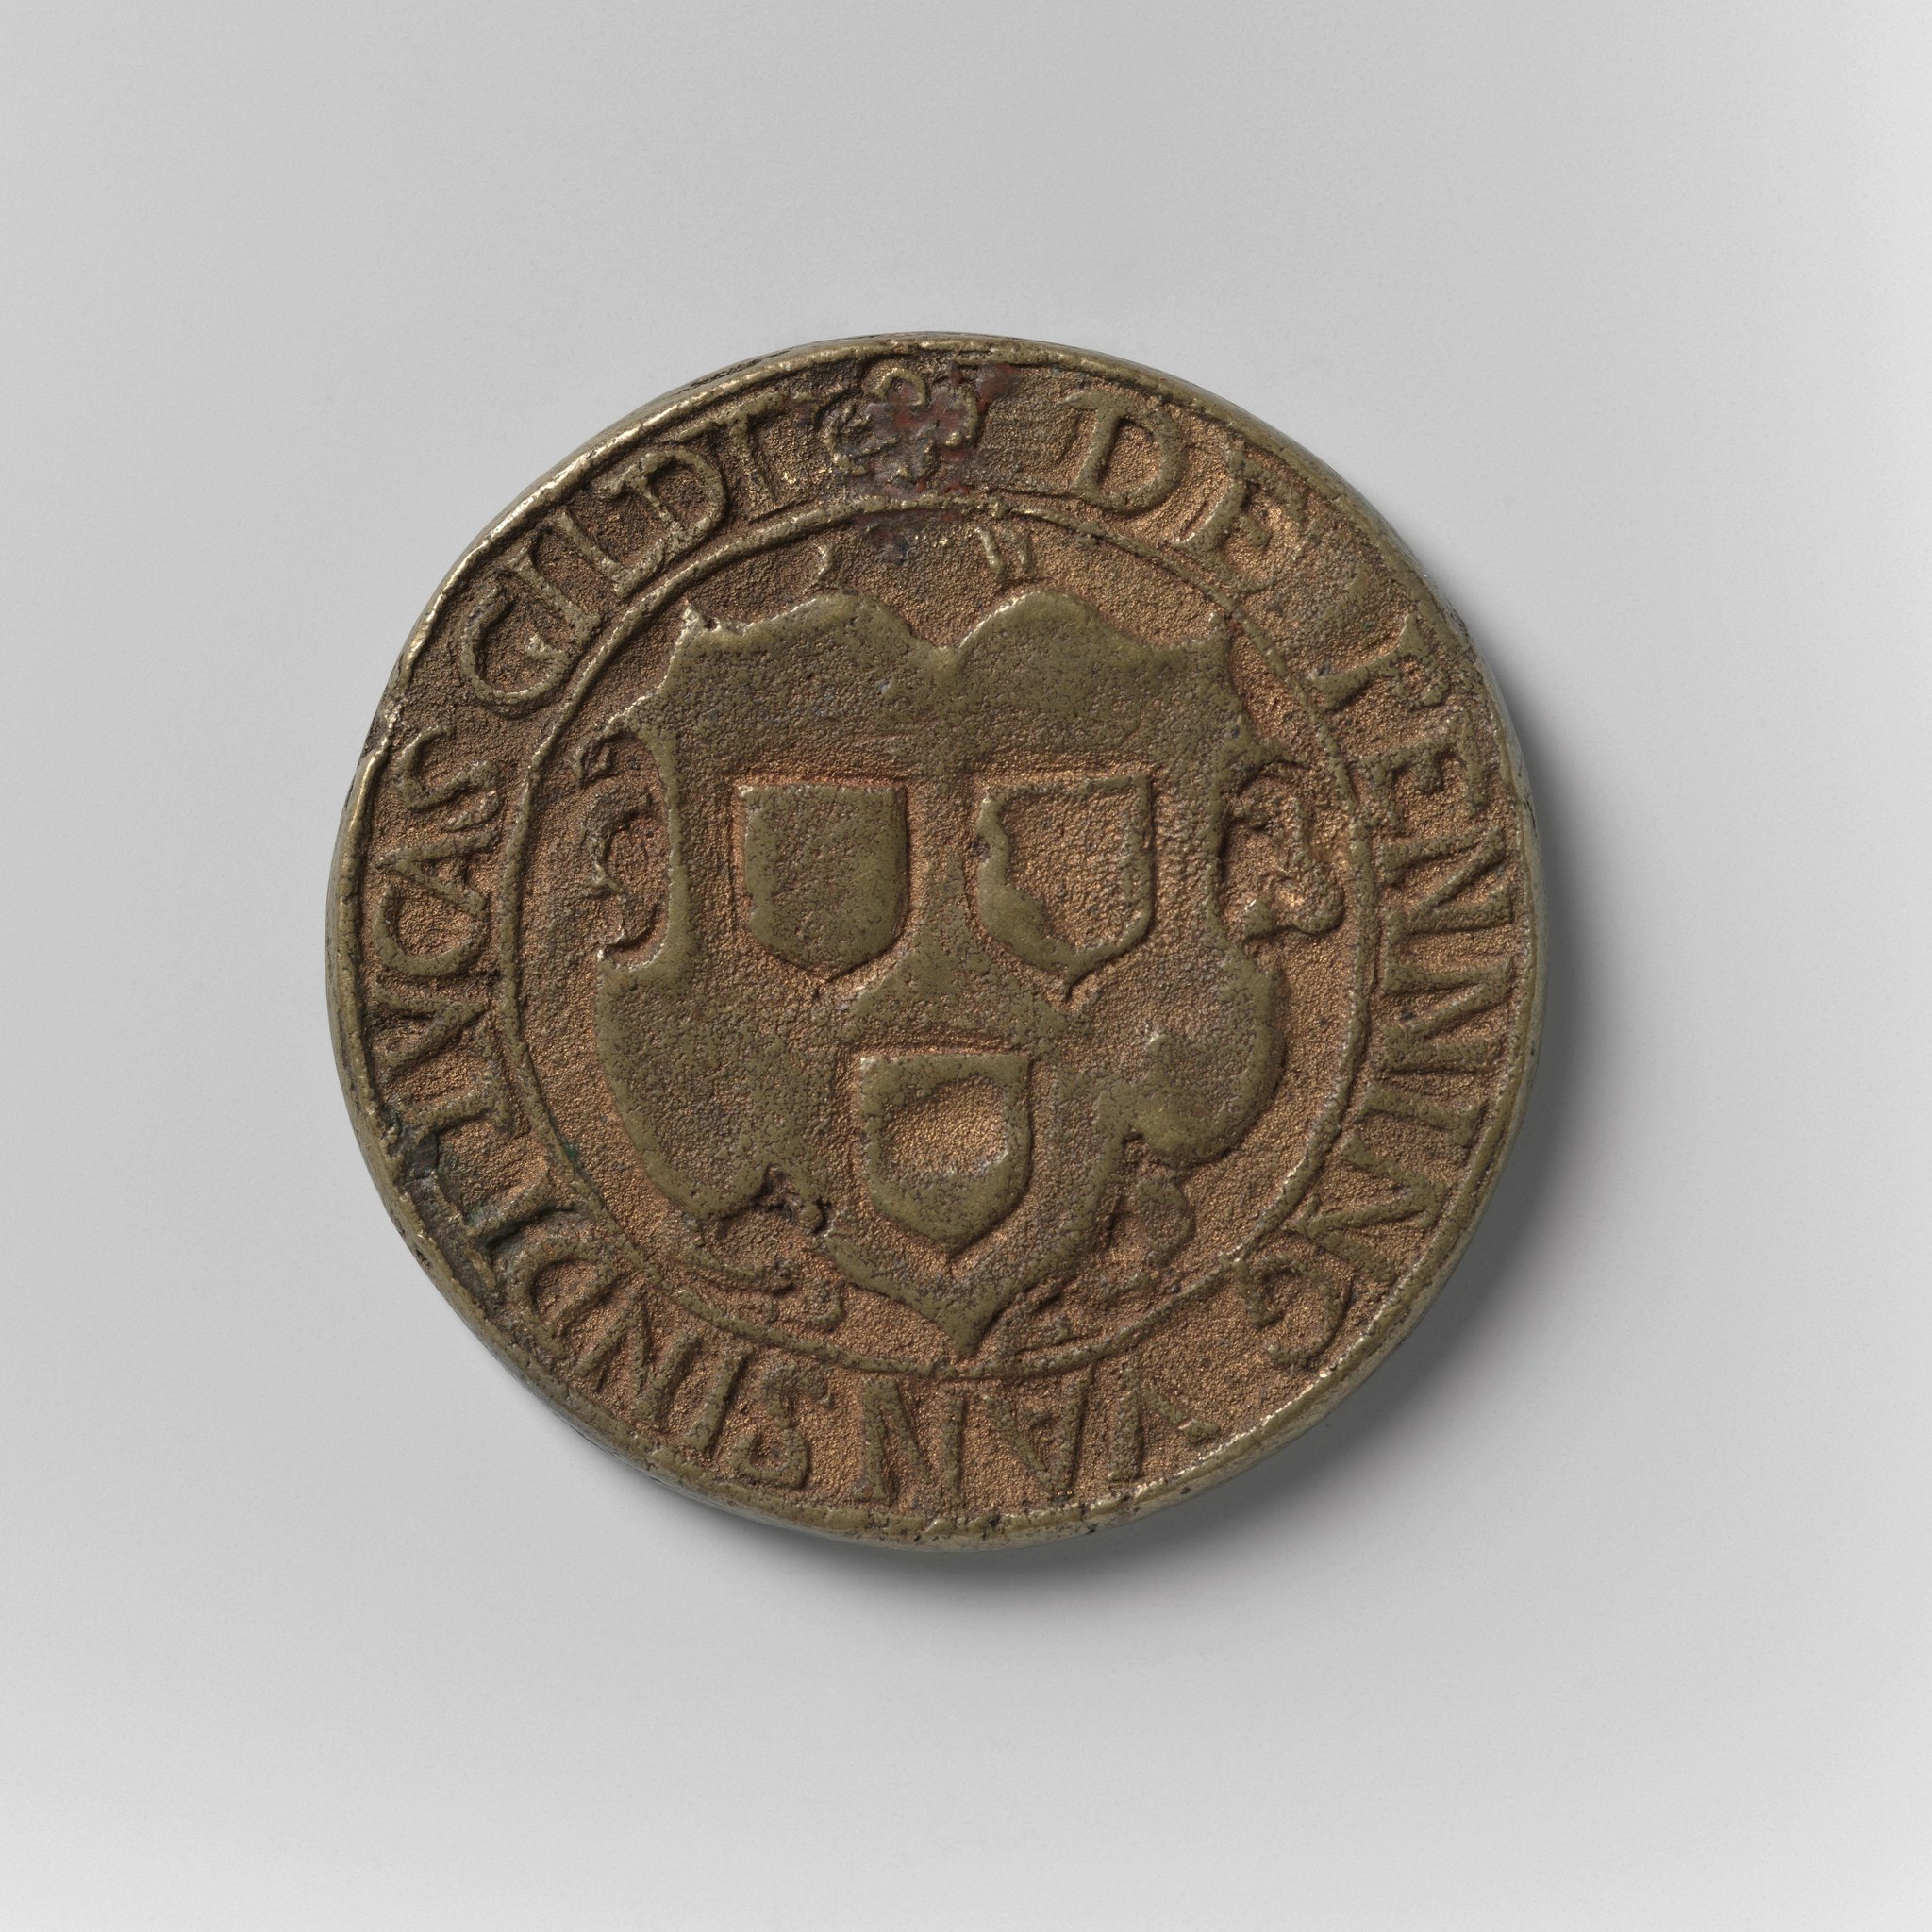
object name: medal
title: Presentiepenning van het Sint Lucas- of Schildersgilde te 's-Gravenhage 1654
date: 1654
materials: brass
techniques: casting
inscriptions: inscription: ‘N / 1654’, circumscription: ‘DE PENNING VAN SINDT LVCAS GILDT (roos)’, inscription: ‘78’, number: ‘6.’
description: Gegoten messing penning, op de voorzijde een lucasschild met omschrift, op de keerzijde twee regels tekst door een koord gescheiden